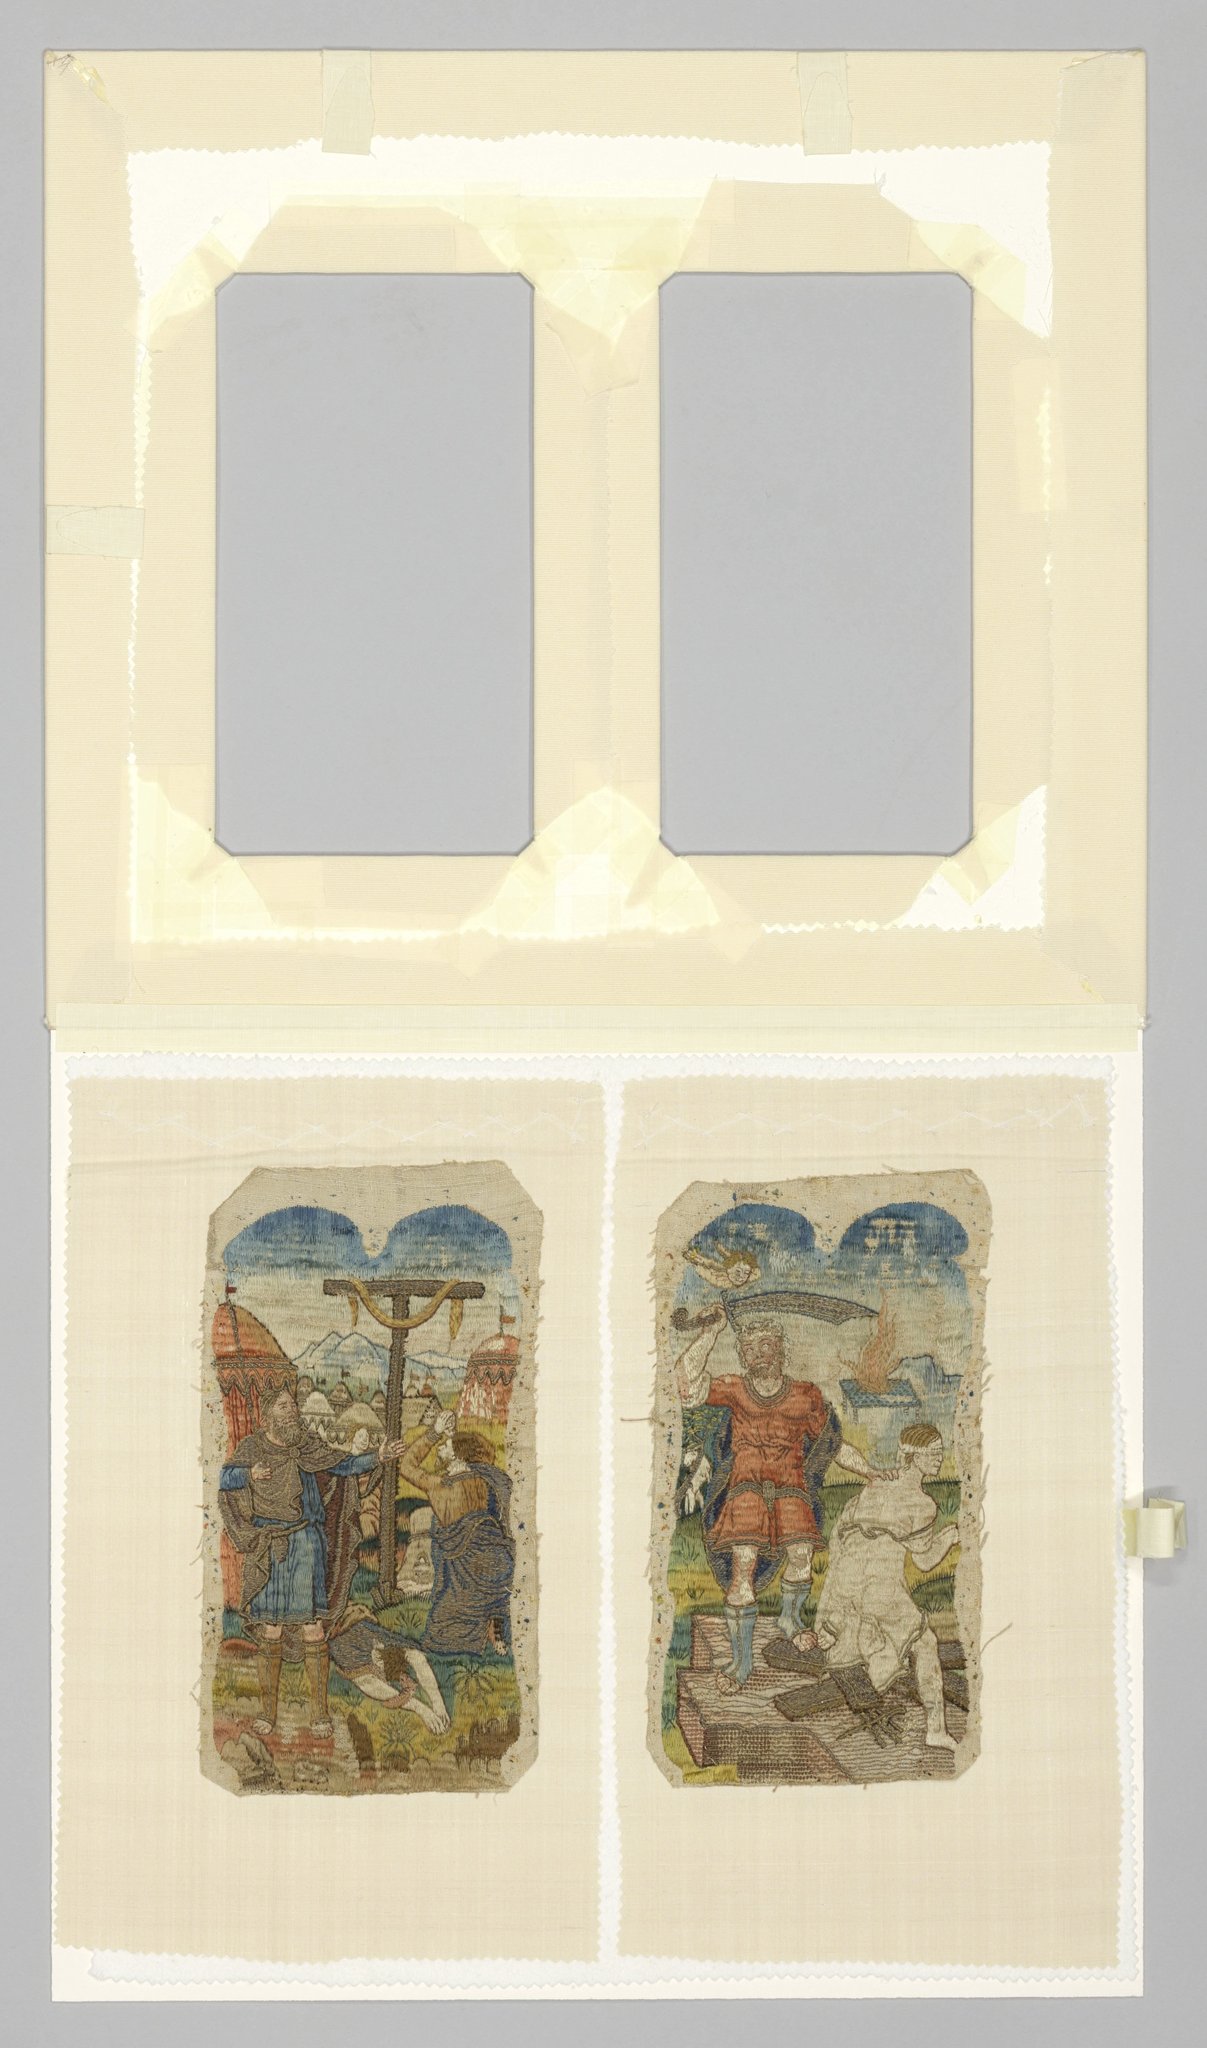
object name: aurifries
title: Aurifries met borduurwerk van zijde en gouddraad op linnen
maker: Anonymous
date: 1525-1530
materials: gold thread, linen, silk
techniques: embroidered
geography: southern netherlands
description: Aurifries met borduurwerk. Het borduurwerk heeft een afbeelding van Mozes en de koperen slang. Onder een baldakijn staat rechts een kruis en links staat Mozes met een staf. Rechts zijn drie geknielde mannen afgebeeld.